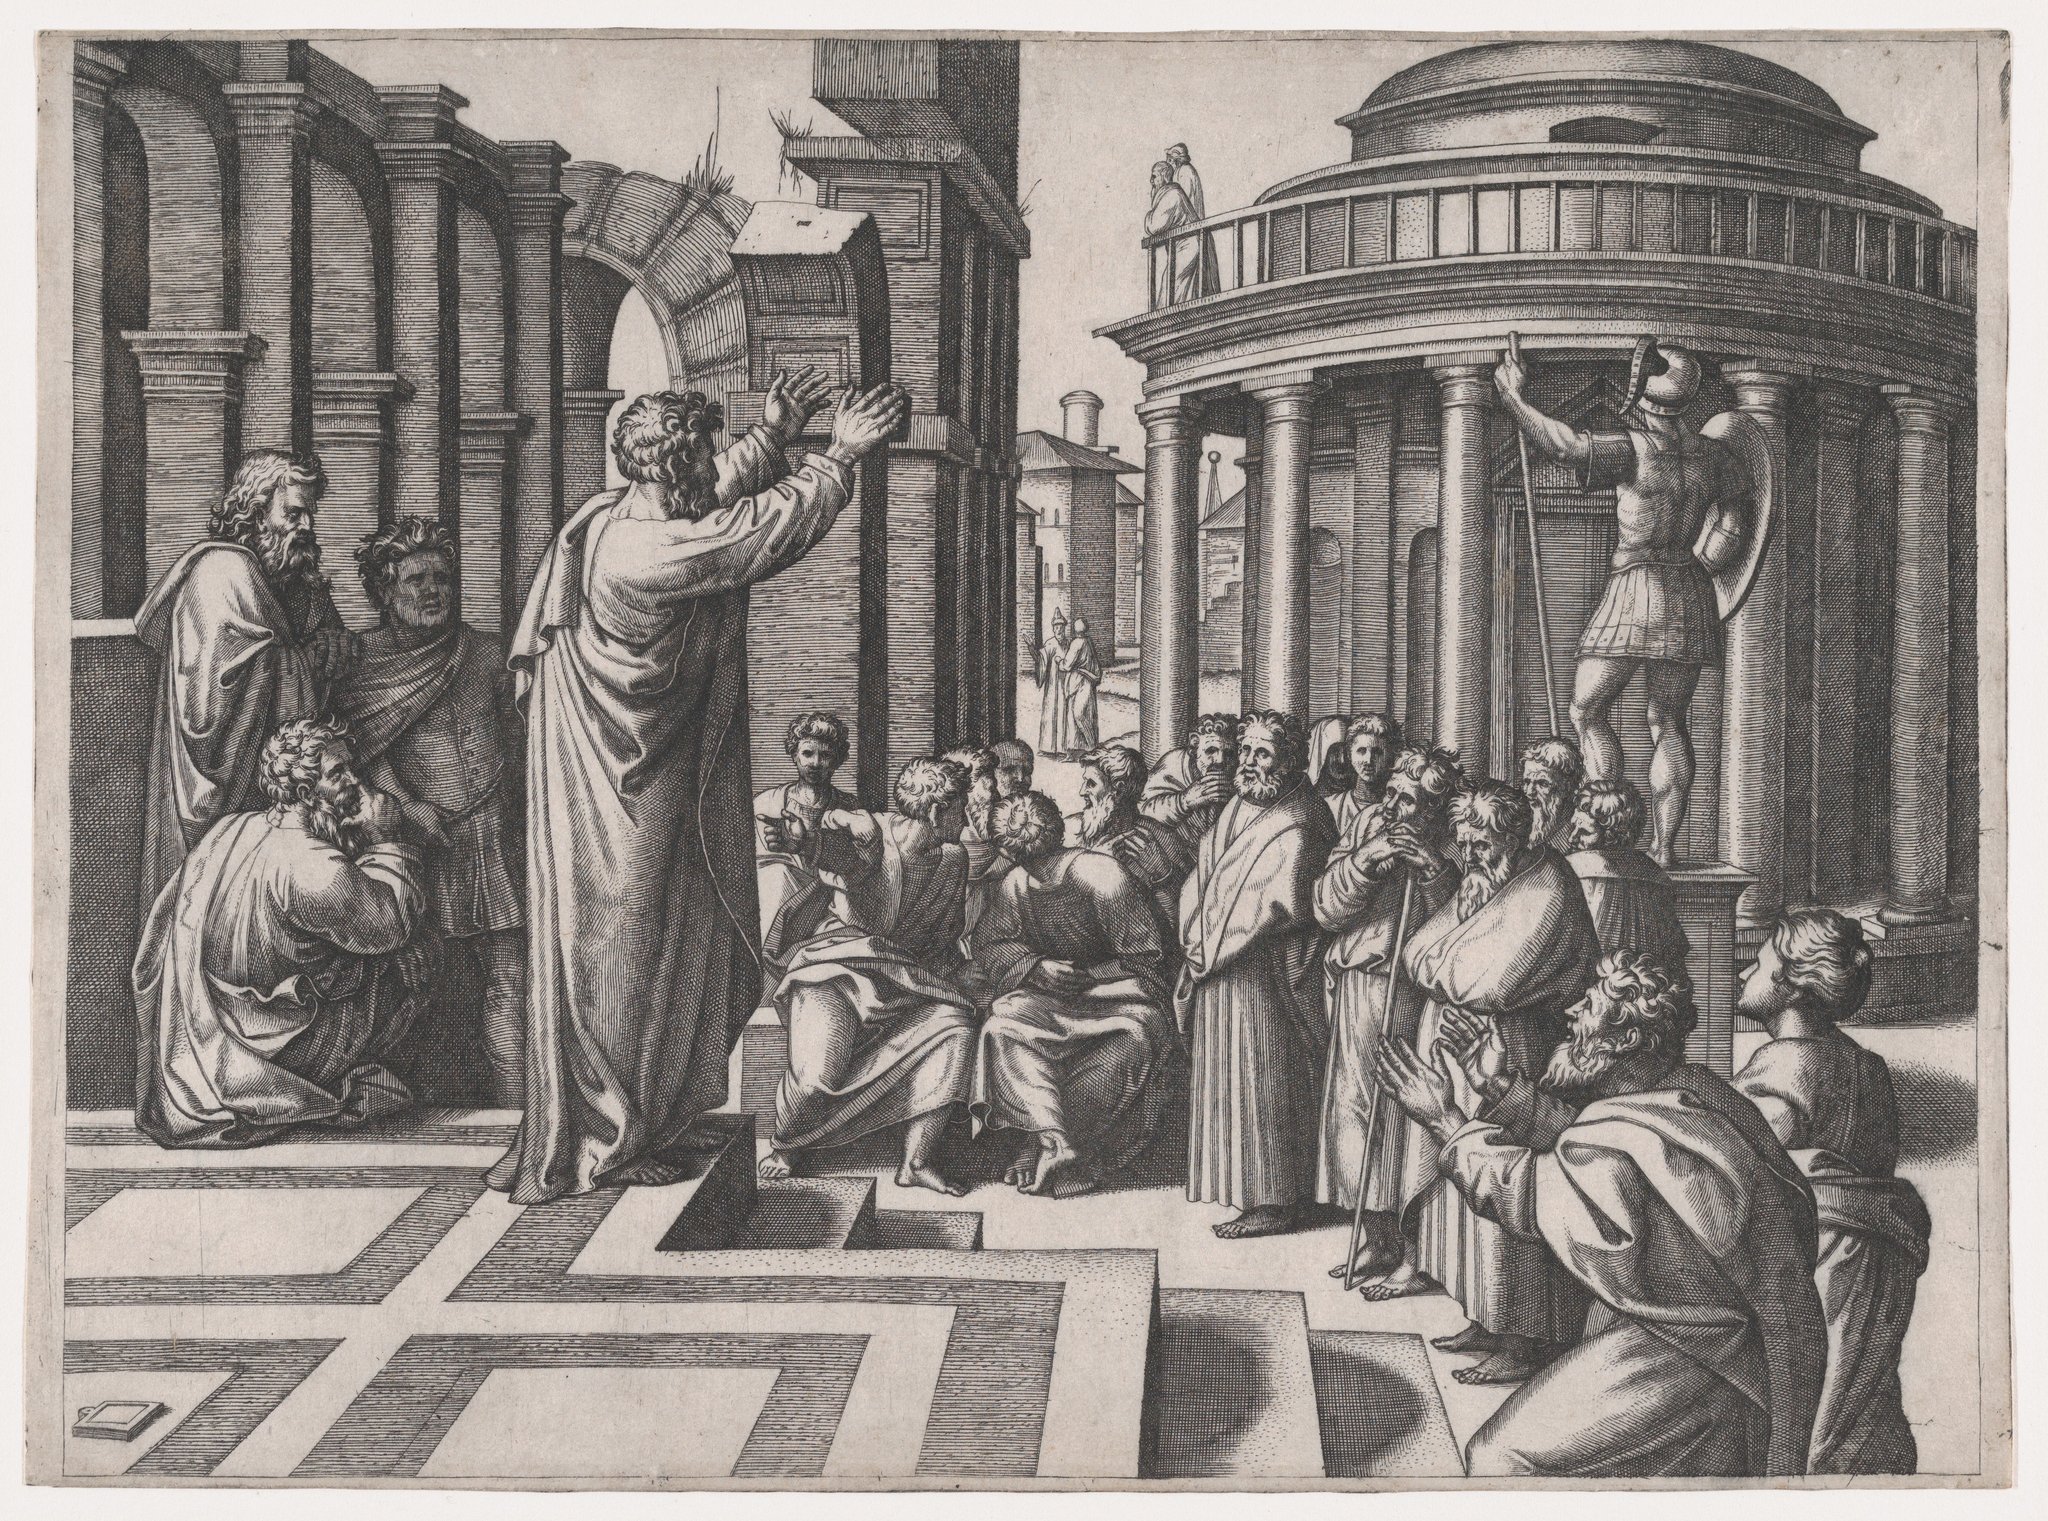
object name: print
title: Saint Paul preaching in Athens, after Raphael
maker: marcantonio raimondi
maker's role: artist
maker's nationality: italian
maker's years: 1475-1534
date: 1517-1520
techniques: engraving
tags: men,saint paul